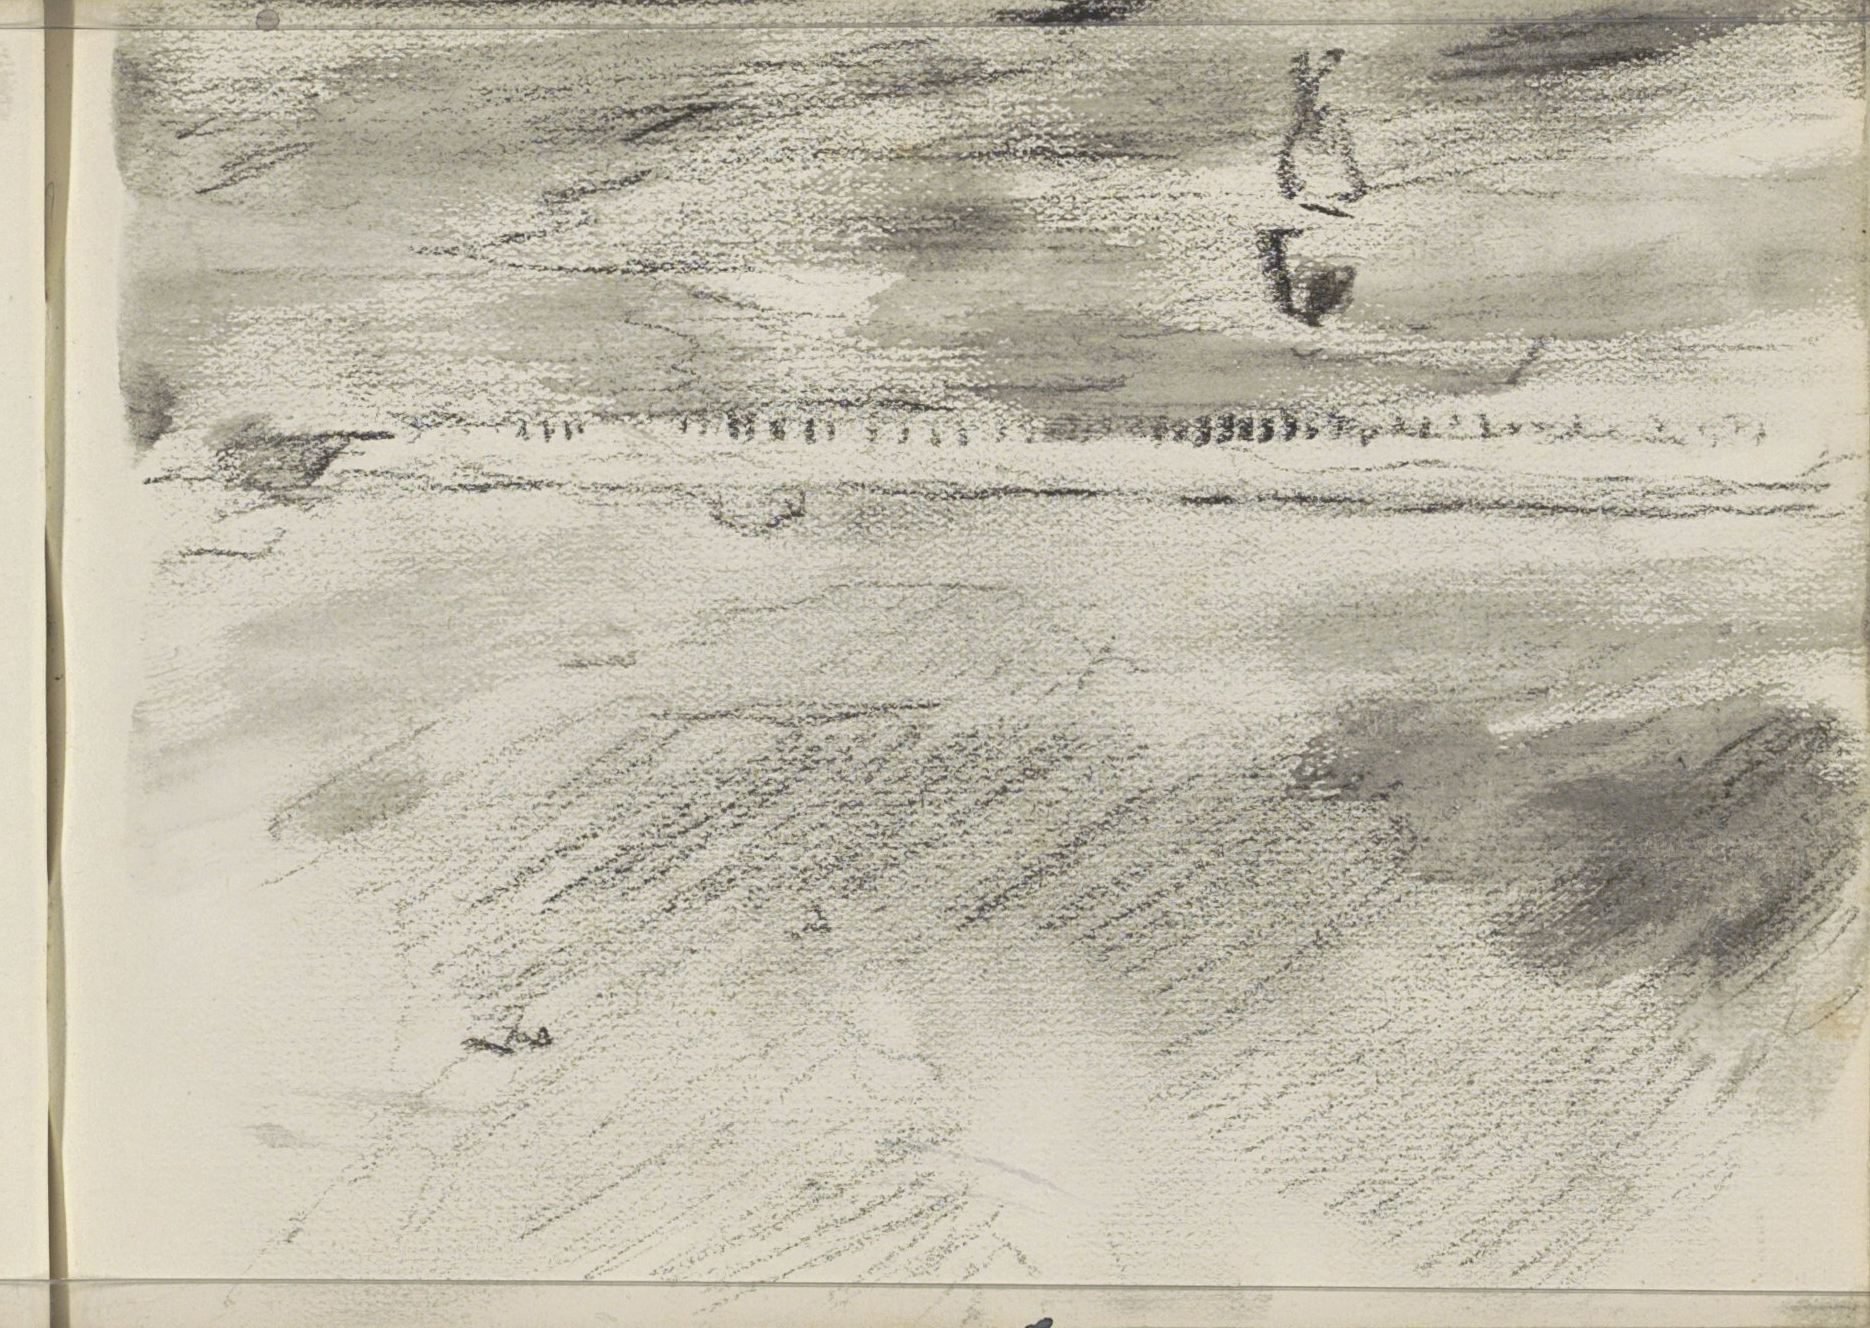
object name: sketchbook leaf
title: Figuur in de branding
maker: johan antonie de jonge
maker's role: draughtsman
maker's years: 1864-1927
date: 1920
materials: chalk, paper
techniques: stumping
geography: south holland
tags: sea (seascape) (+ landscape with figures, staffage)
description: Figuur in de branding. Blad 21 recto uit een schetsboek met 21 bladen.